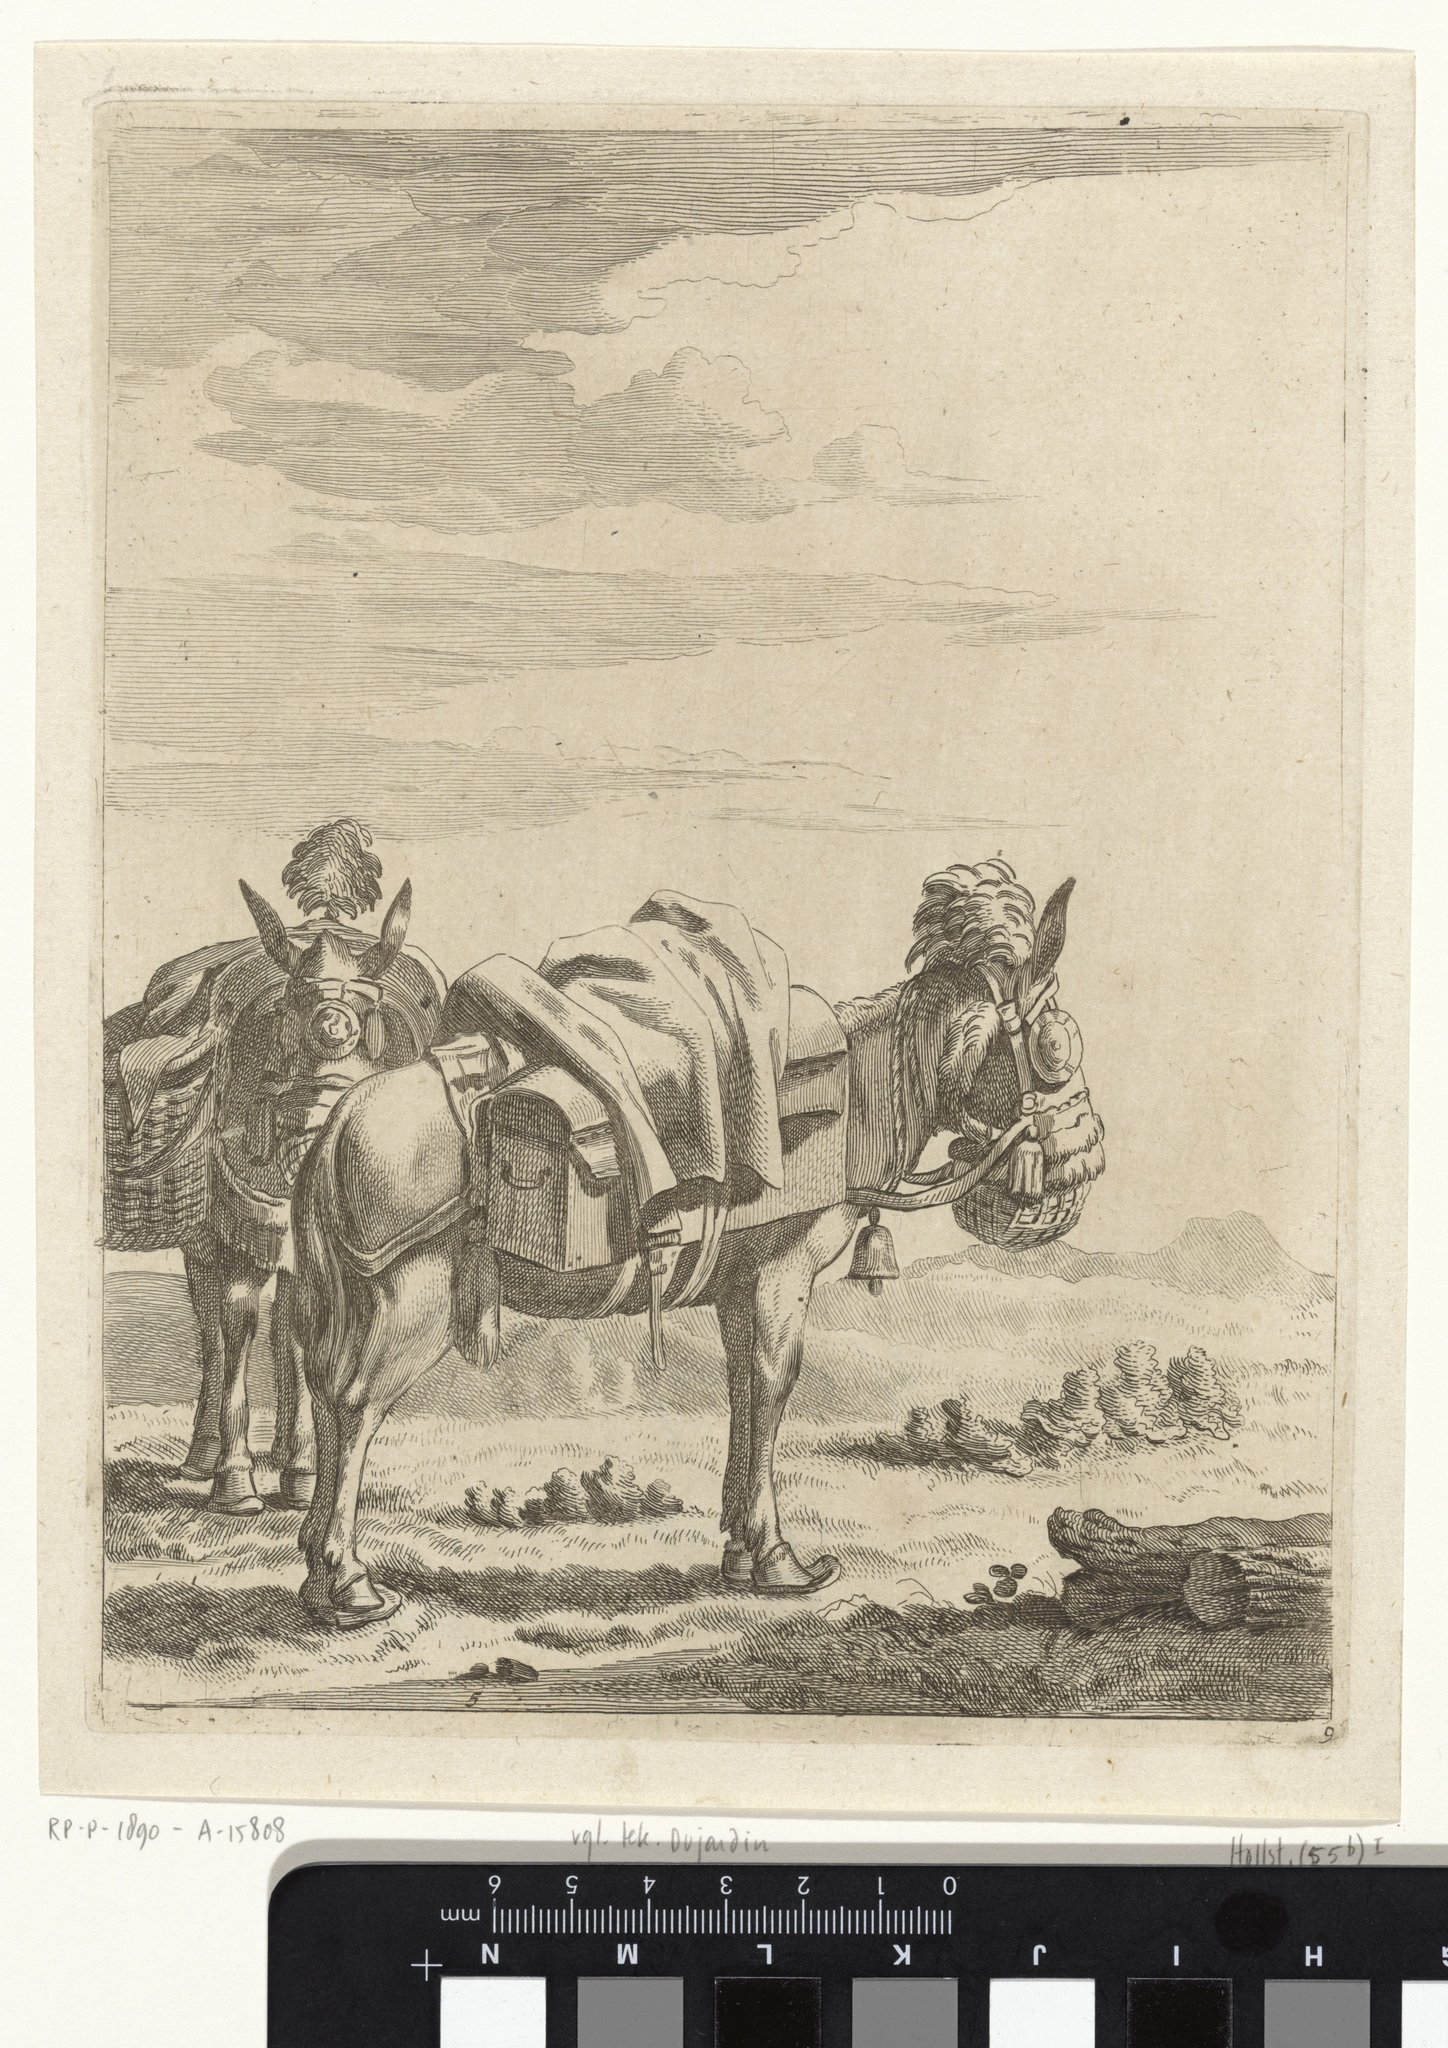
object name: print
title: Diversa Animalia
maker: Anonymous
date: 1643-1692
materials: paper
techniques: engraving, etching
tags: landscapes, ass, donkey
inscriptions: collector's mark: Lugt 2228